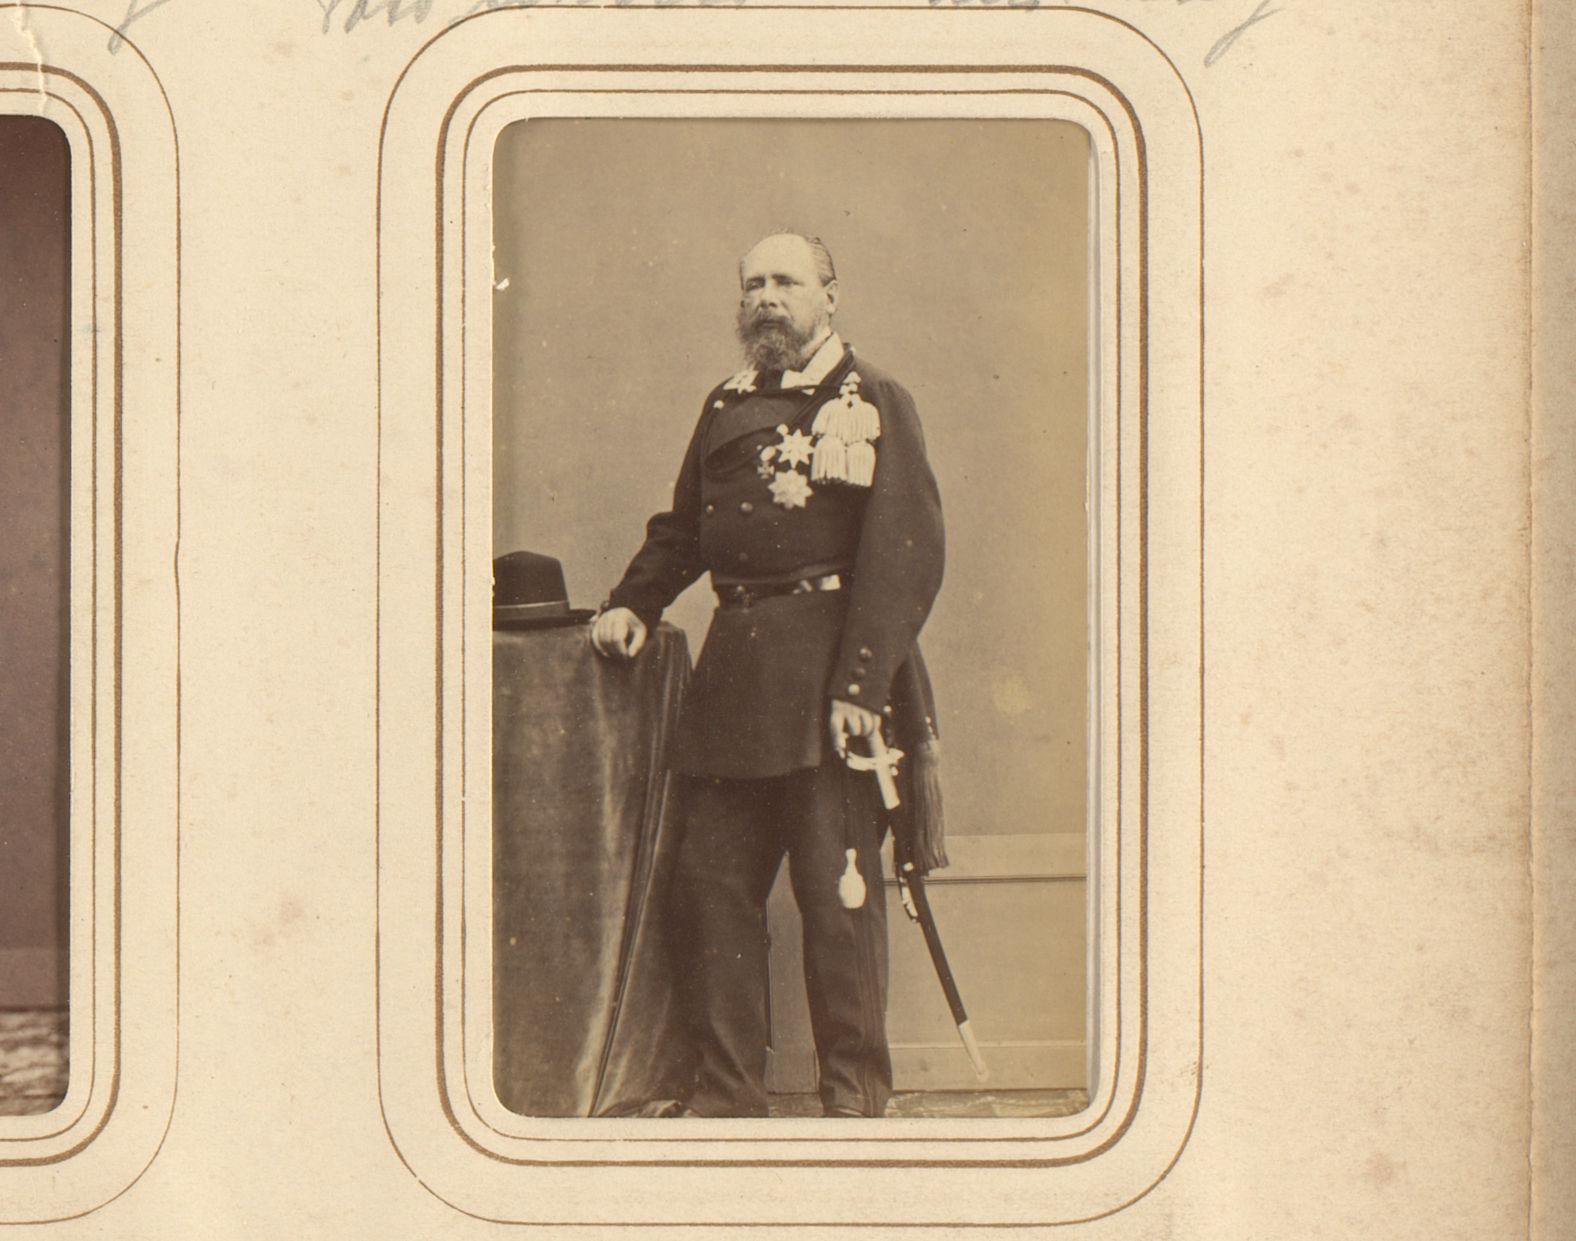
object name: photograph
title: Portret van koning Willem III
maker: robert severin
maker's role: fotograaf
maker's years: 1839-1888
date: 1855-1875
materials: cardboard, photographic support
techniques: albumen print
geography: the hague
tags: brussels, willem iii (koning der nederlanden), adult man, queen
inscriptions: inscription: ‘R. Severin/ Photographe de S.M. le Roi / Noordeinde, 109./ La Haye’, inscription: ‘R. Severin Phot. La Haye.’